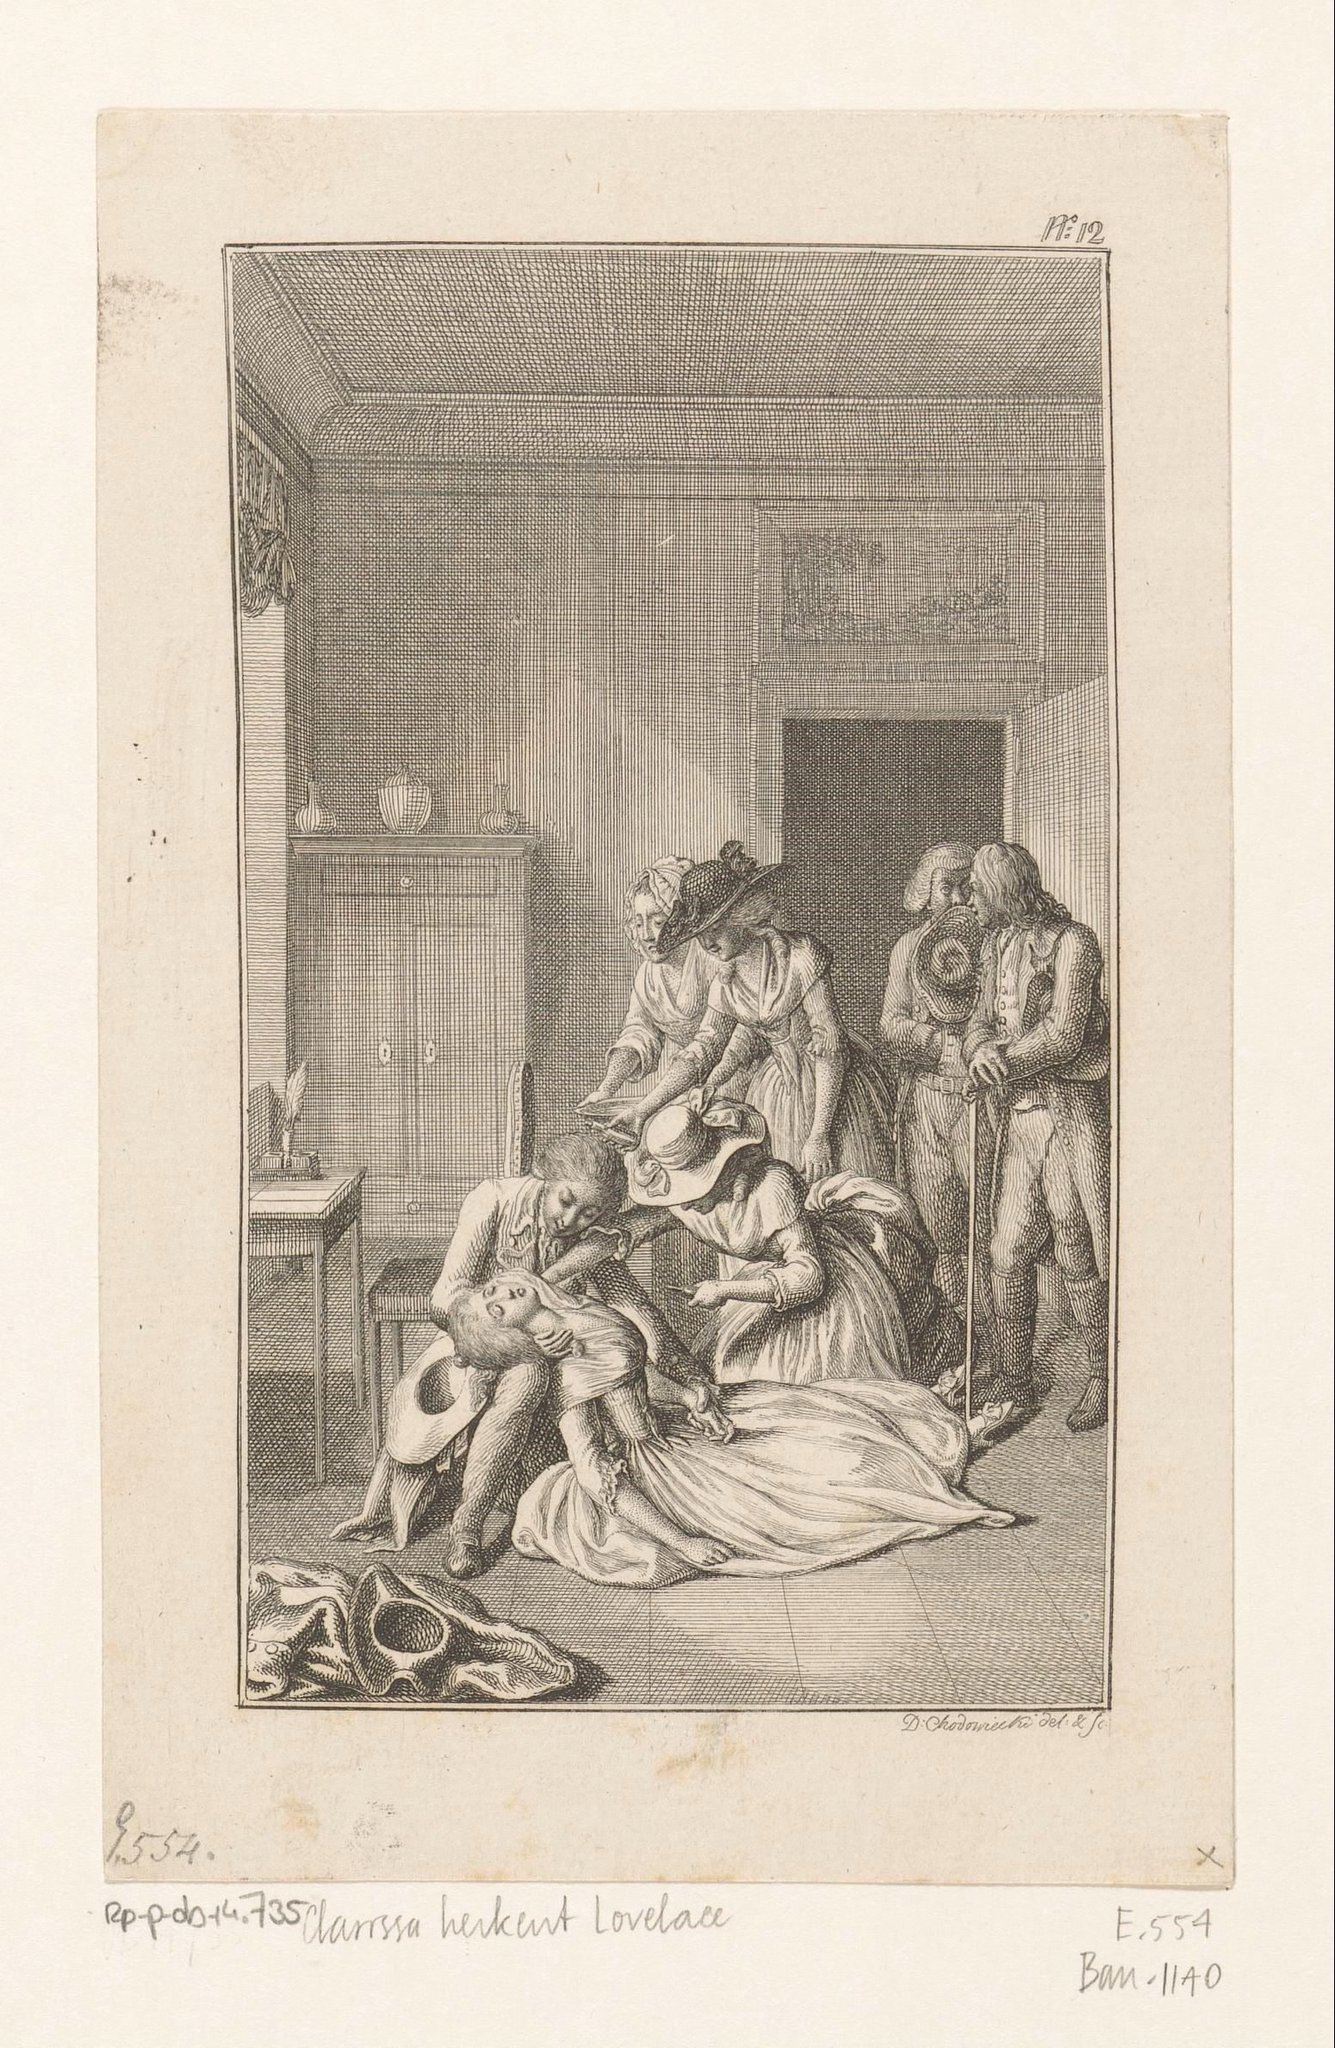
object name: print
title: Clarissa herkent Lovelace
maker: daniel nikolaus chodowiecki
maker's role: draughtsman, print maker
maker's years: 1726-1801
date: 1784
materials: paper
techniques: etching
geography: berlin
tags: fainting, swooning, literature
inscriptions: collector's mark: Lugt 2228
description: Prent gebruikt voor: Richardson, Samuel. Clarisse Harlowe, Traduction nouvelle et seule complete par (...). 14 dln. Genève en Parijs: Barde, 1785-87.